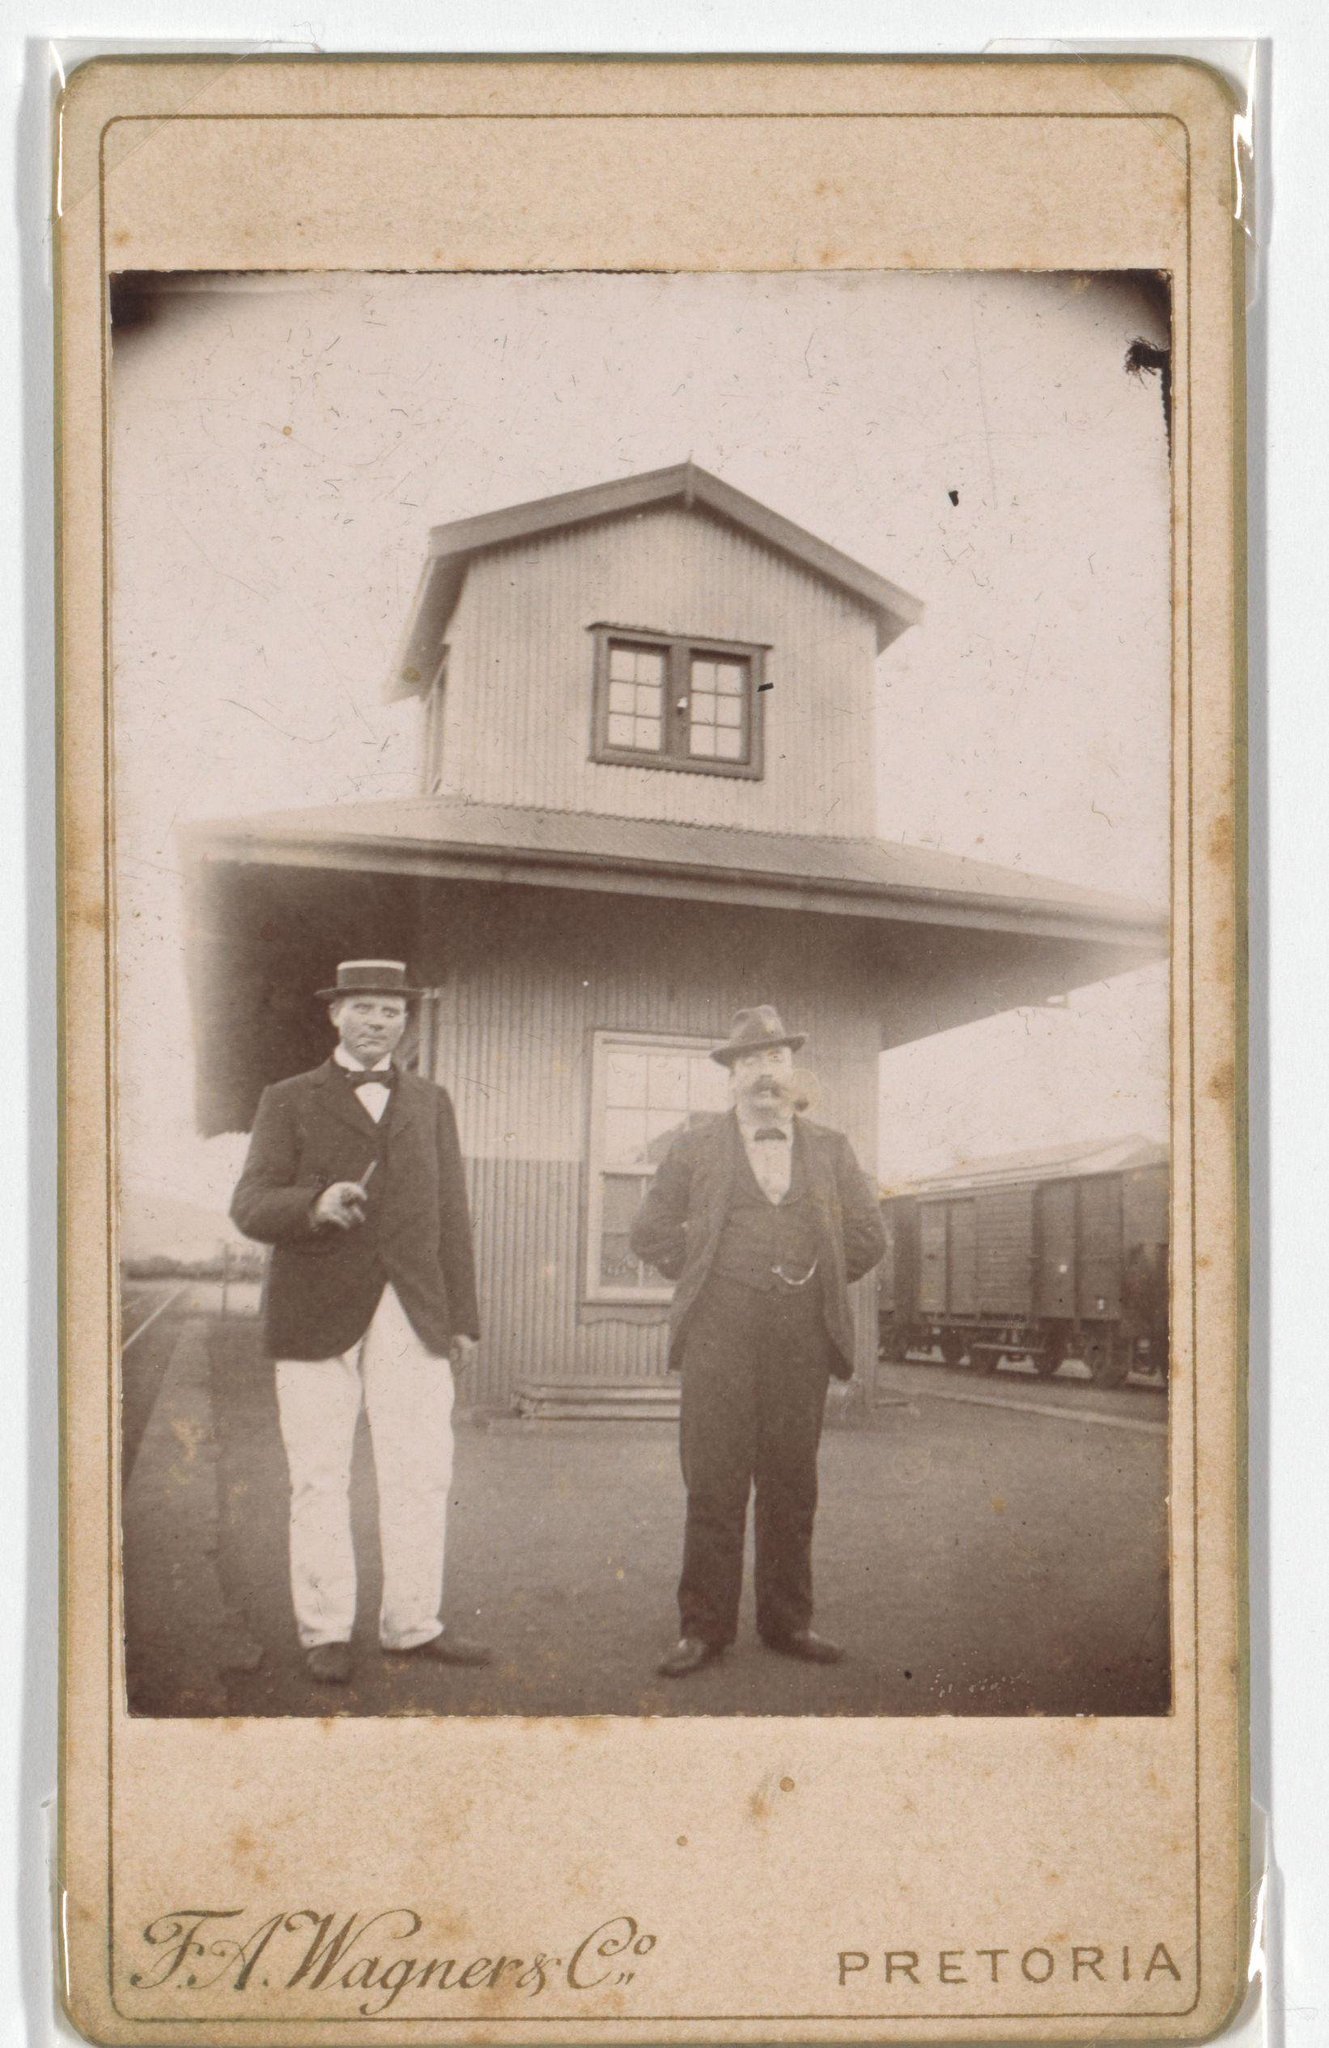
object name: carte de visite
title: Twee mannen op een perron kort voor het uitbreken van de Tweede Boerenoorlog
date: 1899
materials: cardboard, paper, photographic support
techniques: daylight paper print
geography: pretoria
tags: historical persons, station; shelter (railway, tramway)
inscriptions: inscription: ‘Zondagmiddag 5 uur. 8 october 1899’